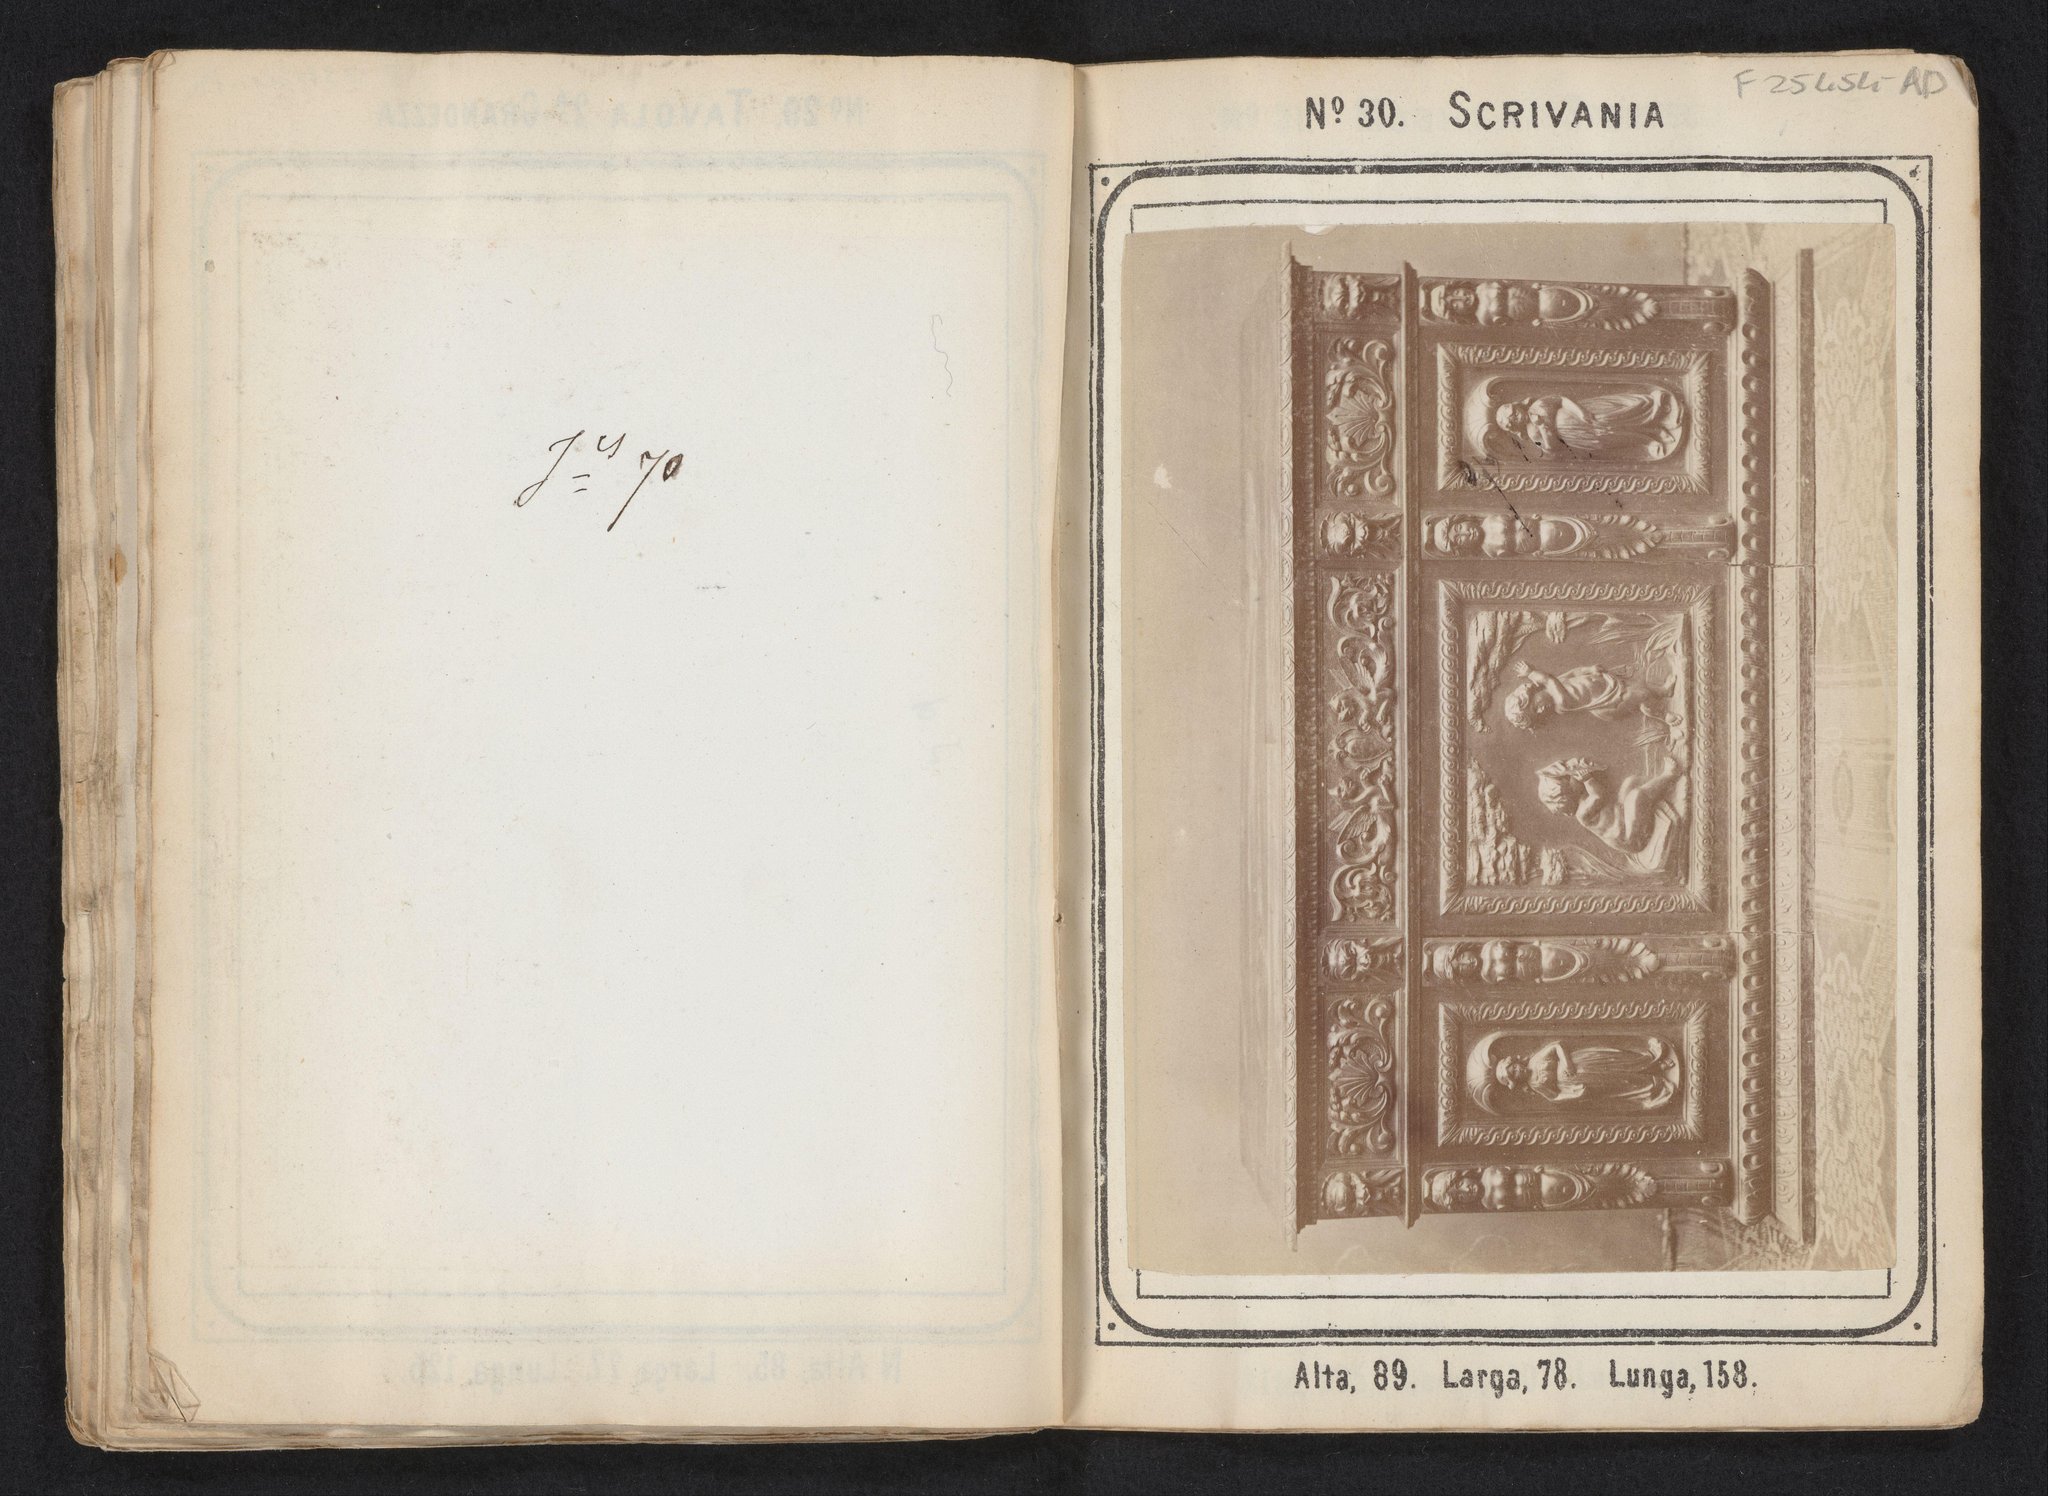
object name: page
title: No 30 Scrivania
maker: Anonymous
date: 1878-1885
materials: paper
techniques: albumen print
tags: writing-table, writing-desk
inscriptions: inscription: ‘Alta, 89. Larga, 78. Lunga, 158.’